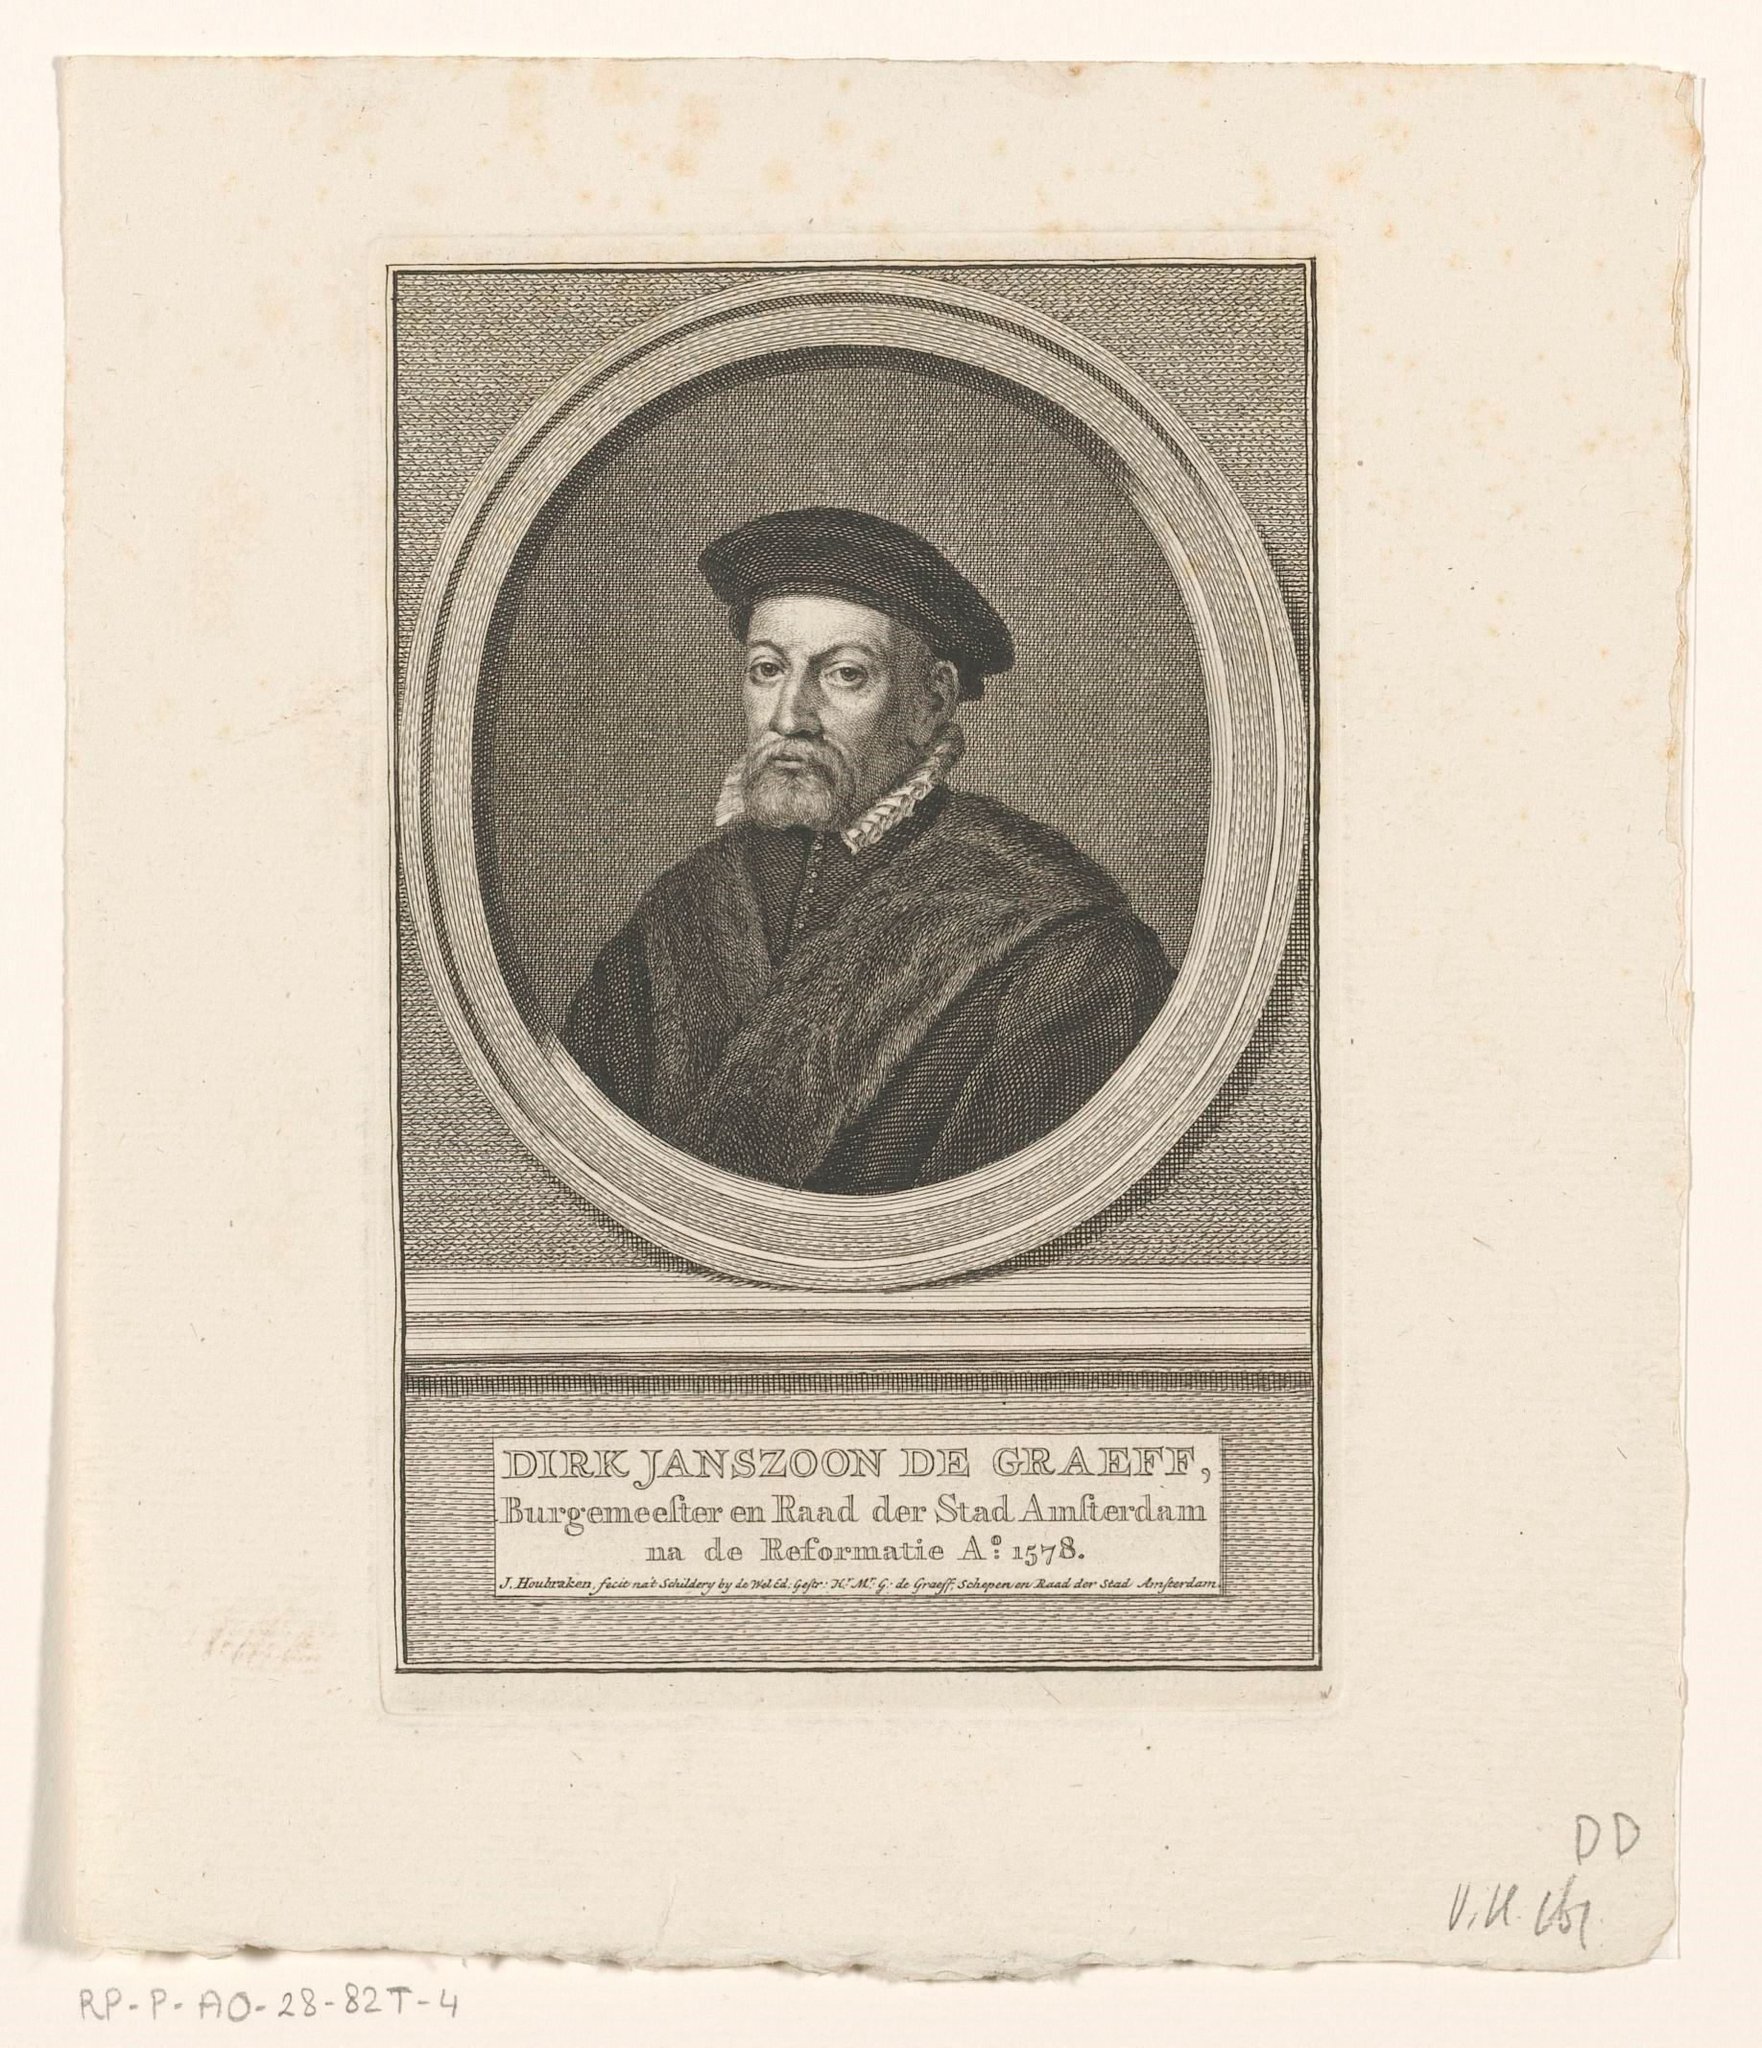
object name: print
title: Portret van Dirk Janszoon de Graeff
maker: jacob houbraken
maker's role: draughtsman, print maker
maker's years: 1698-1780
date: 1749-1780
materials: paper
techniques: engraving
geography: amsterdam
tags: politician, historical persons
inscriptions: collector's mark: Lugt 2228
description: Deze prent is oorspronkelijk bedoeld als aanvulling op Jan Wagenaars ‘Vaderlandsche historie’* en was zo vanaf 1796 verkrijgbaar bij Johannes Allart te Amsterdam. Voor de advertentie waarin Allart de 60 portretten en 7 platen, allen gegraveerd door Houbraken, ter aanvulling op Wagenaars ‘Vaderlandsche historie’ aanbiedt, zie RP-P-OB-77.766. *Van dit werk zijn in de achttiende eeuw meerdere uitgaves verschenen, zoals: Wagenaar, Jan. Vaderlandsche historie, vervattende de geschiedenissen der Vereenigde Nederlanden (…). 21 delen. Amsterdam: Isaak Tirion, 1749-1759. Wagenaar, Jan. Vaderlandsche historie, vervattende de geschiedenissen der nu Vereenigde Nederlanden (…). 21 delen. Amsterdam: weduwe Isaak Tirion, 1770. Wagenaar, Jan. Vaderlandsche historie, vervattende de geschiedenissen der nu Vereenigde Nederlanden (…). 21 delen. Amsterdam, Leiden, Dordrecht en Harlingen: P. Schouten e.a., 1782. Wagenaar, Jan. Vaderlandsche historie, vervattende de geschiedenissen der nu Vereenigde Nederlanden (…). 21 delen. Amsterdam: Johannes Allart, 1790-1796.